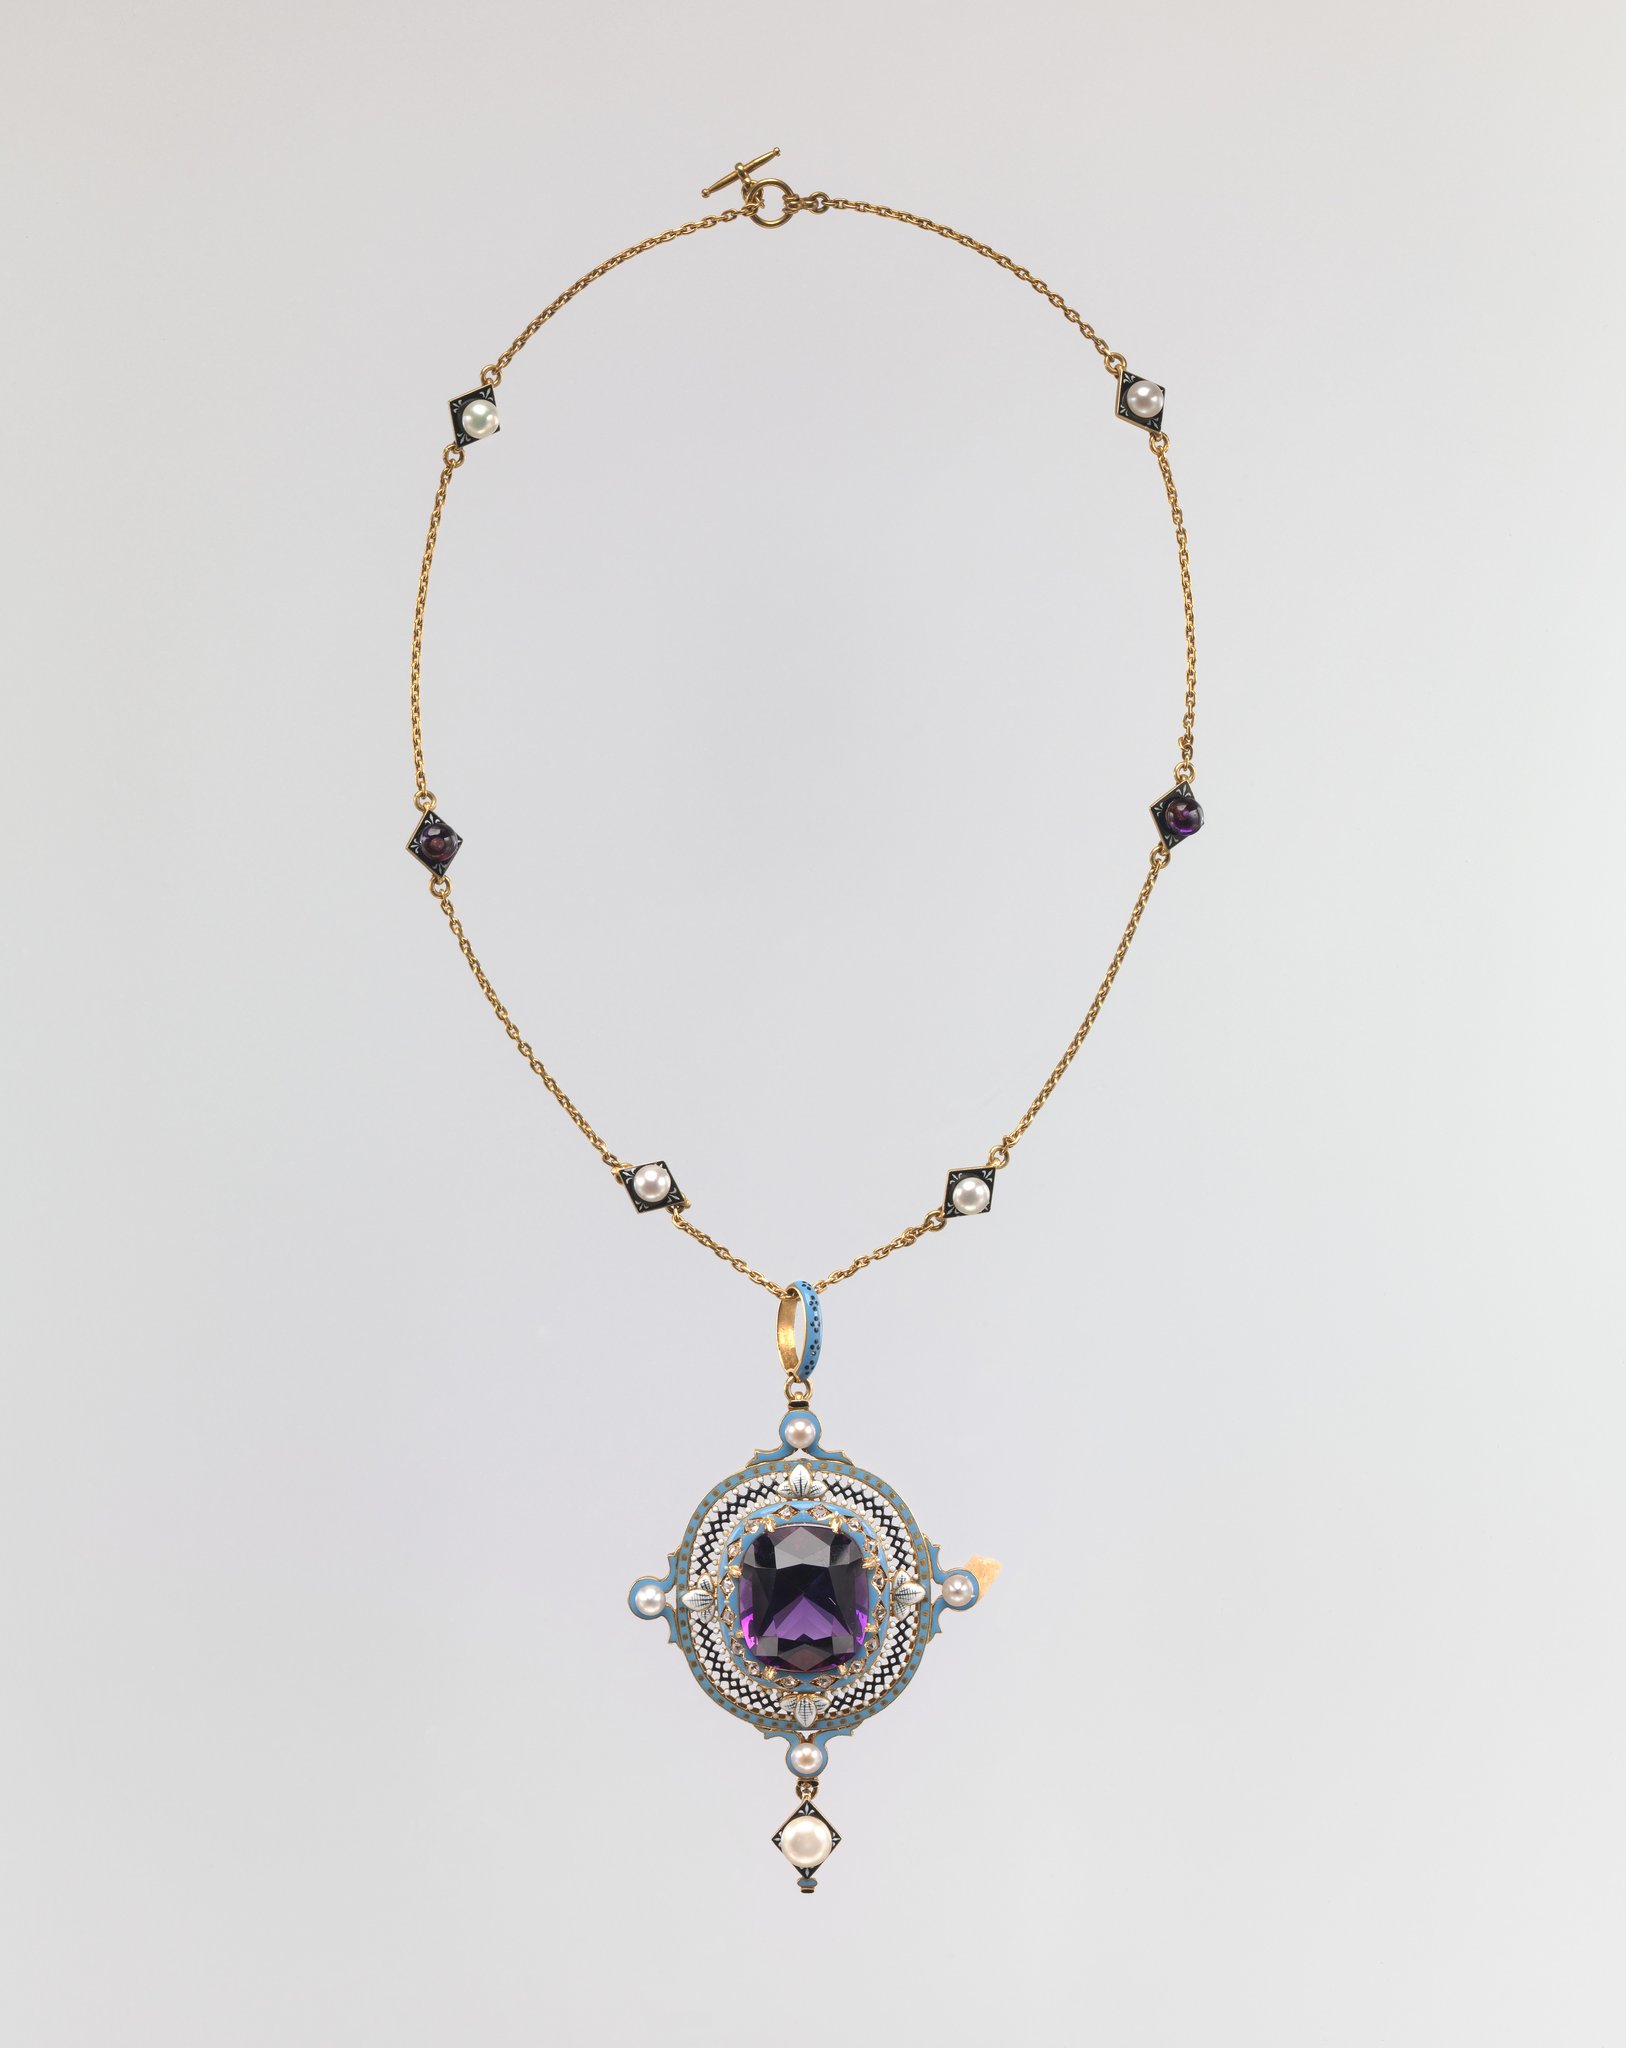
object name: pendant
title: Renaissance revival pendant on chain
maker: carlo giuliano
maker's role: maker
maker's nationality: italian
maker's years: 1831-1895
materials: gemstone, diamond, enamel, gold, pearl